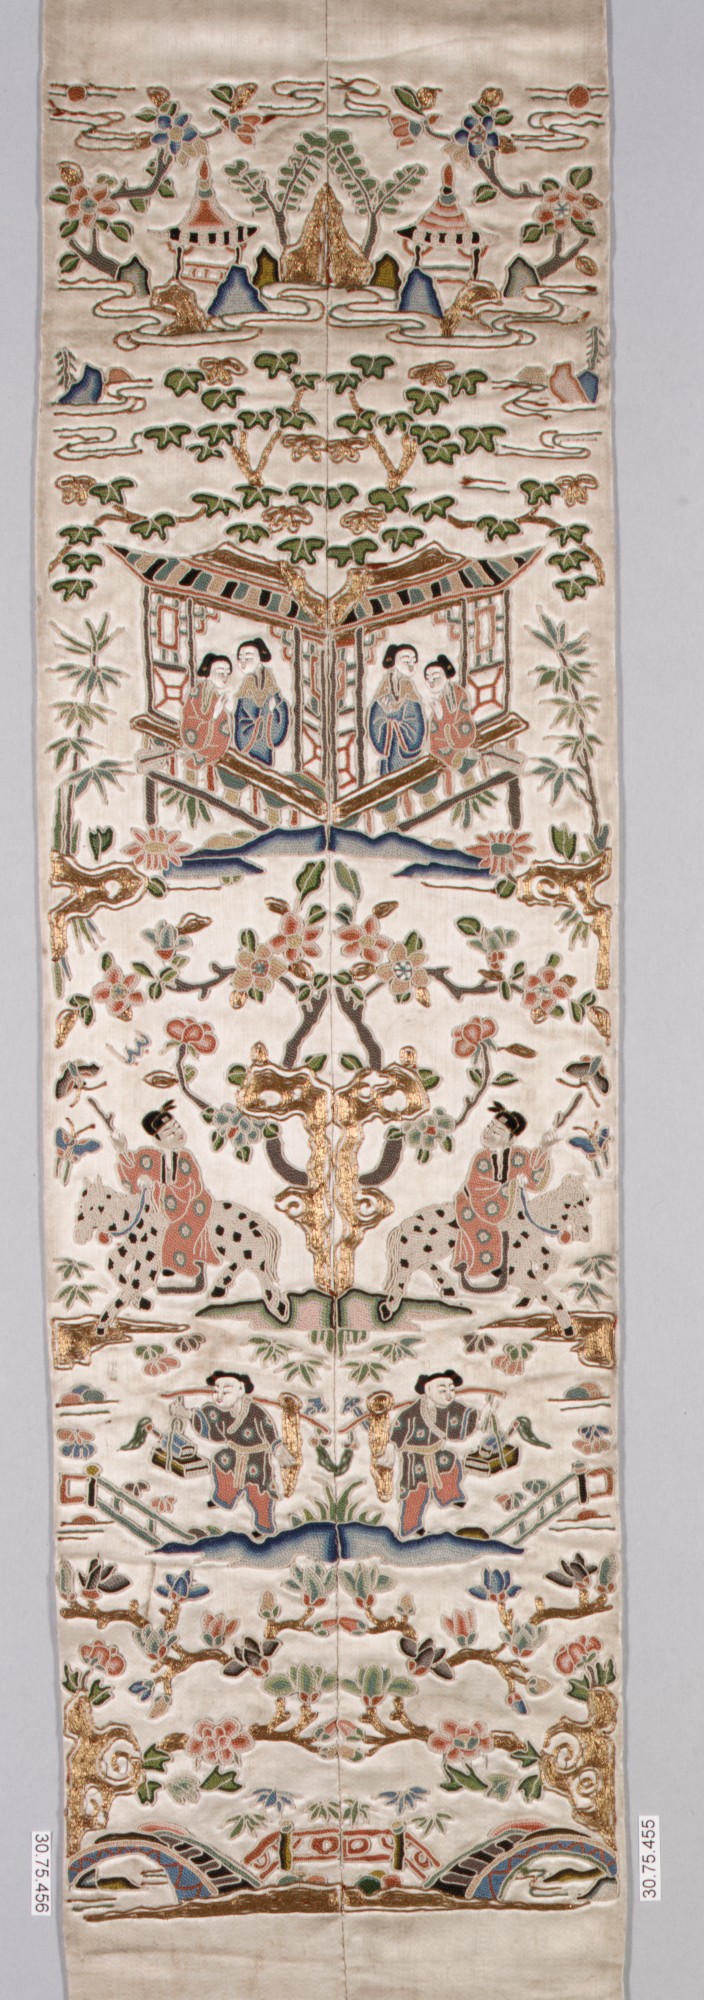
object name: sleeve band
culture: chinese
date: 1801-1900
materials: metal thread, silk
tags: human figures,trees,pavilions